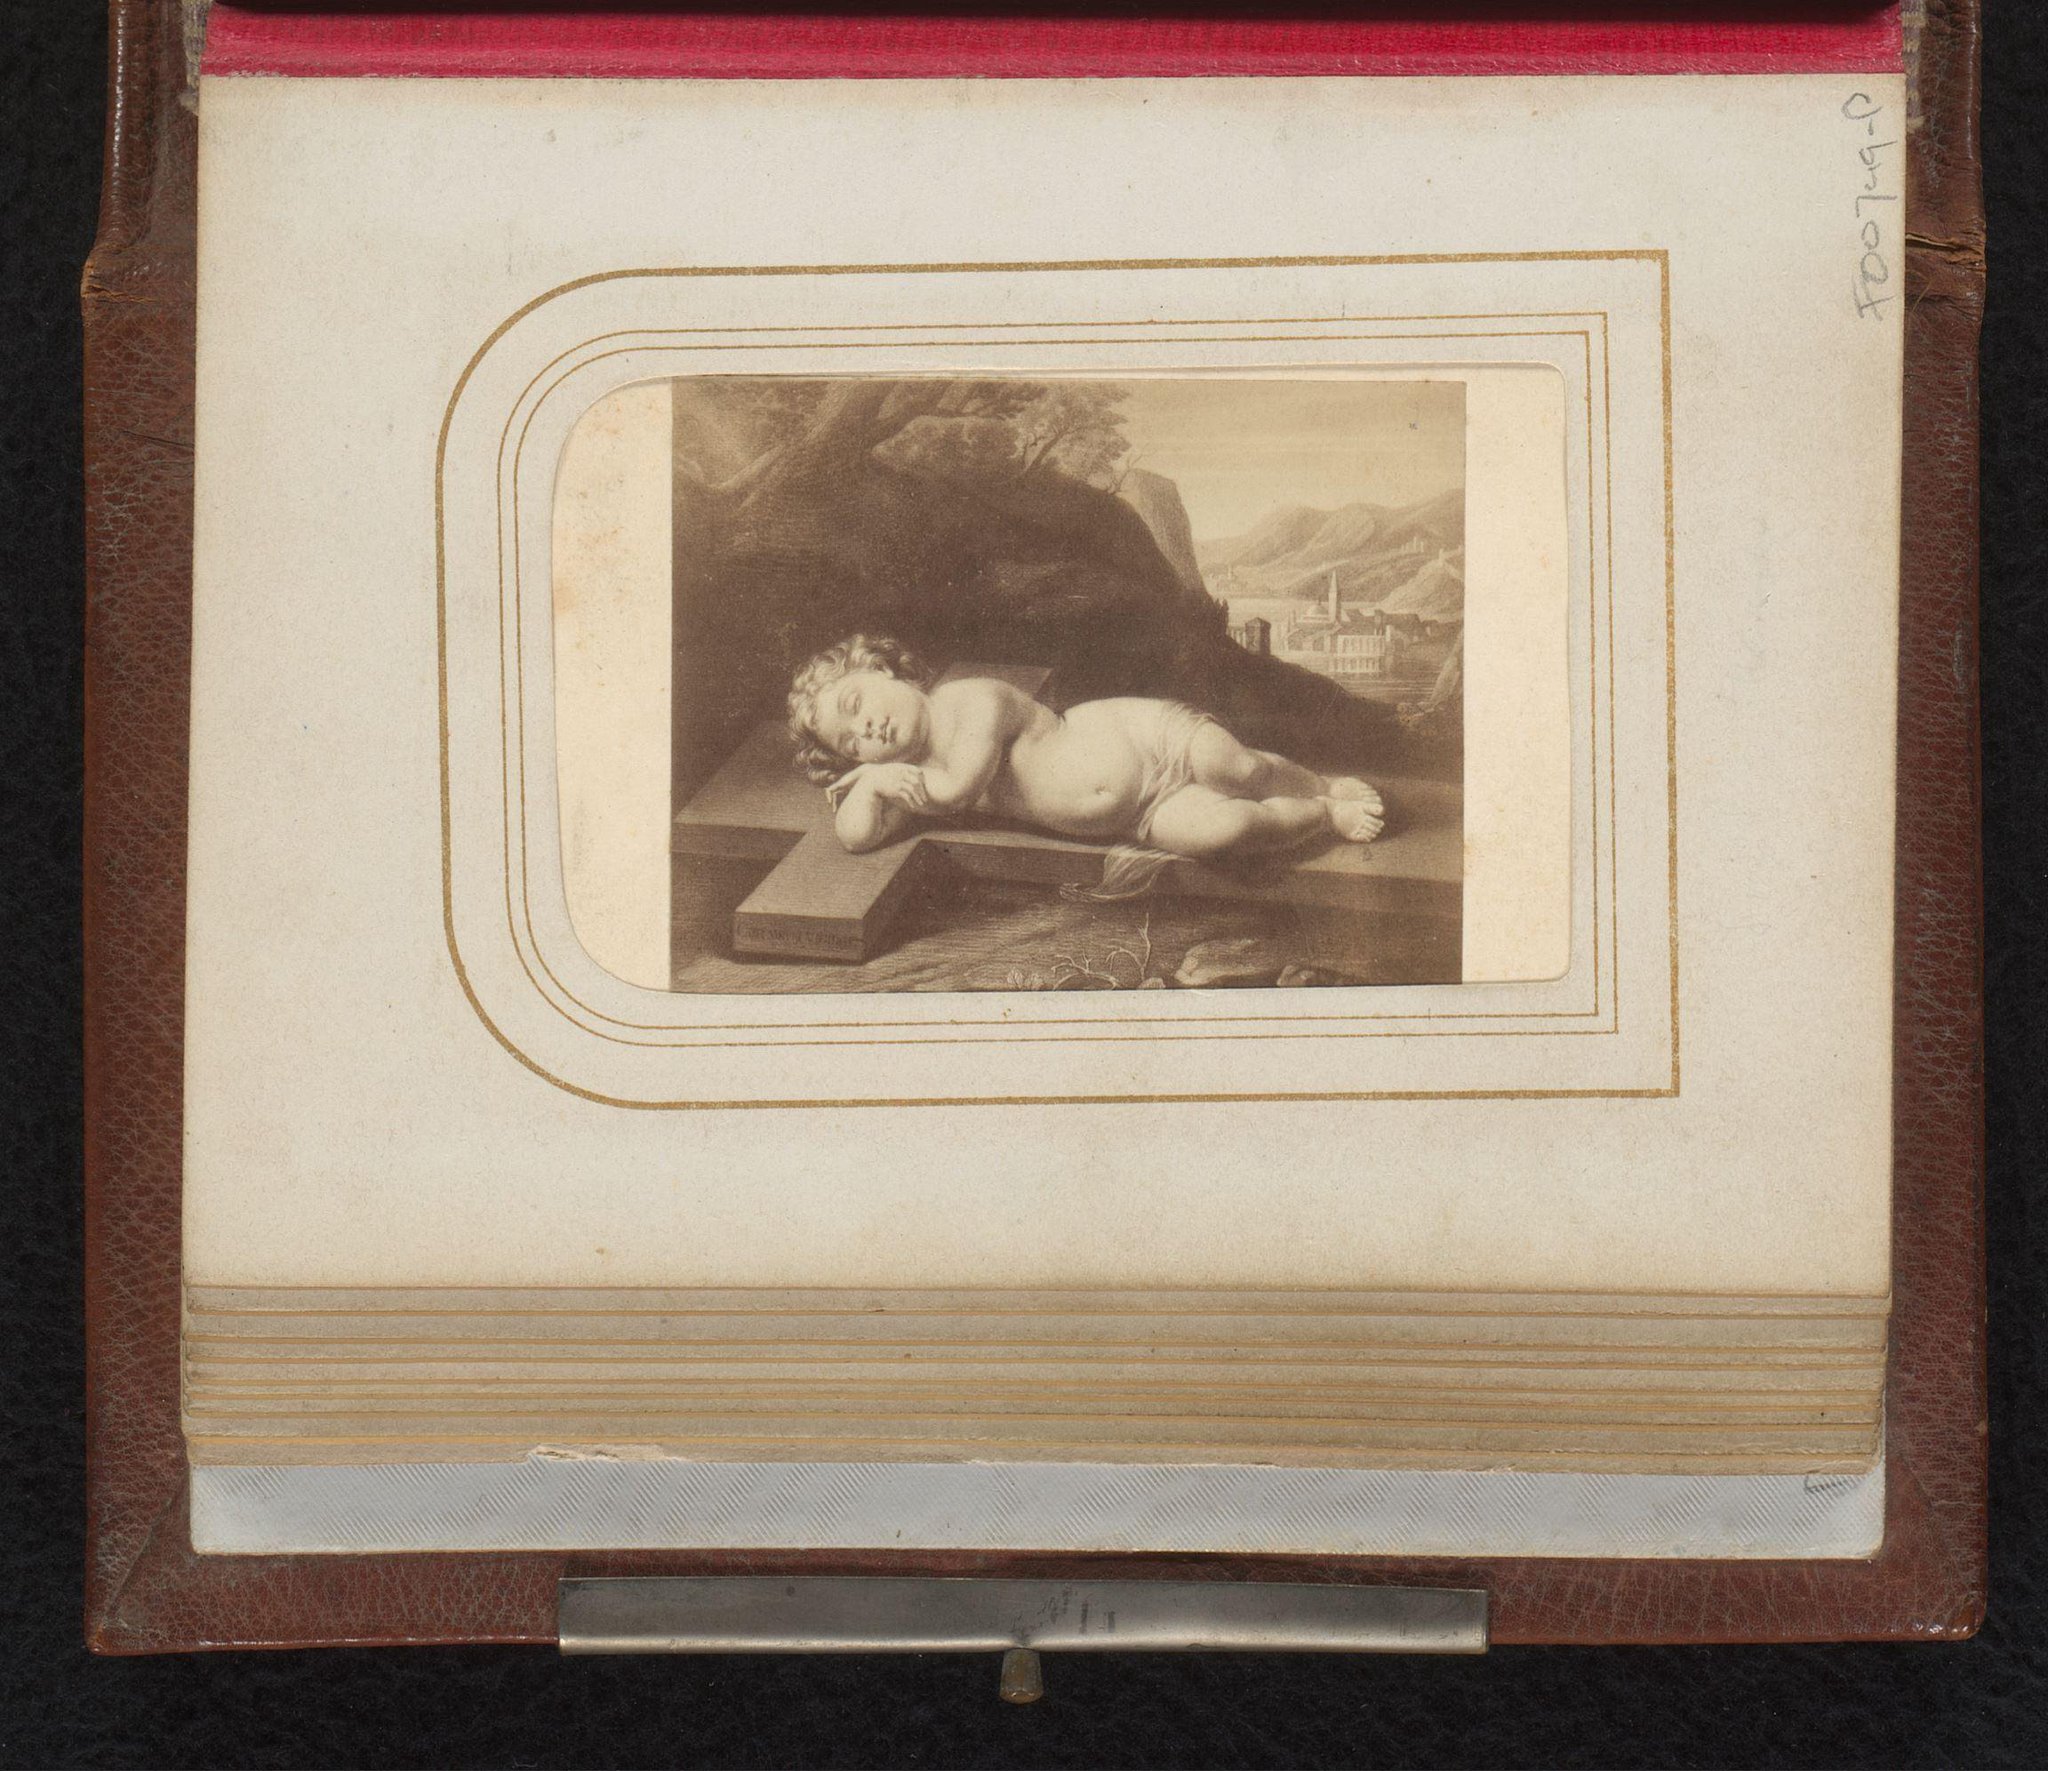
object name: reproduction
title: Fotoreproductie van een prent met Christus als kind, slapend op een kruis door Francesco Albani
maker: Anonymous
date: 1865-1900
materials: cardboard, photographic support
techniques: albumen print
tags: christ as child or youth (in general) ~ christian religion